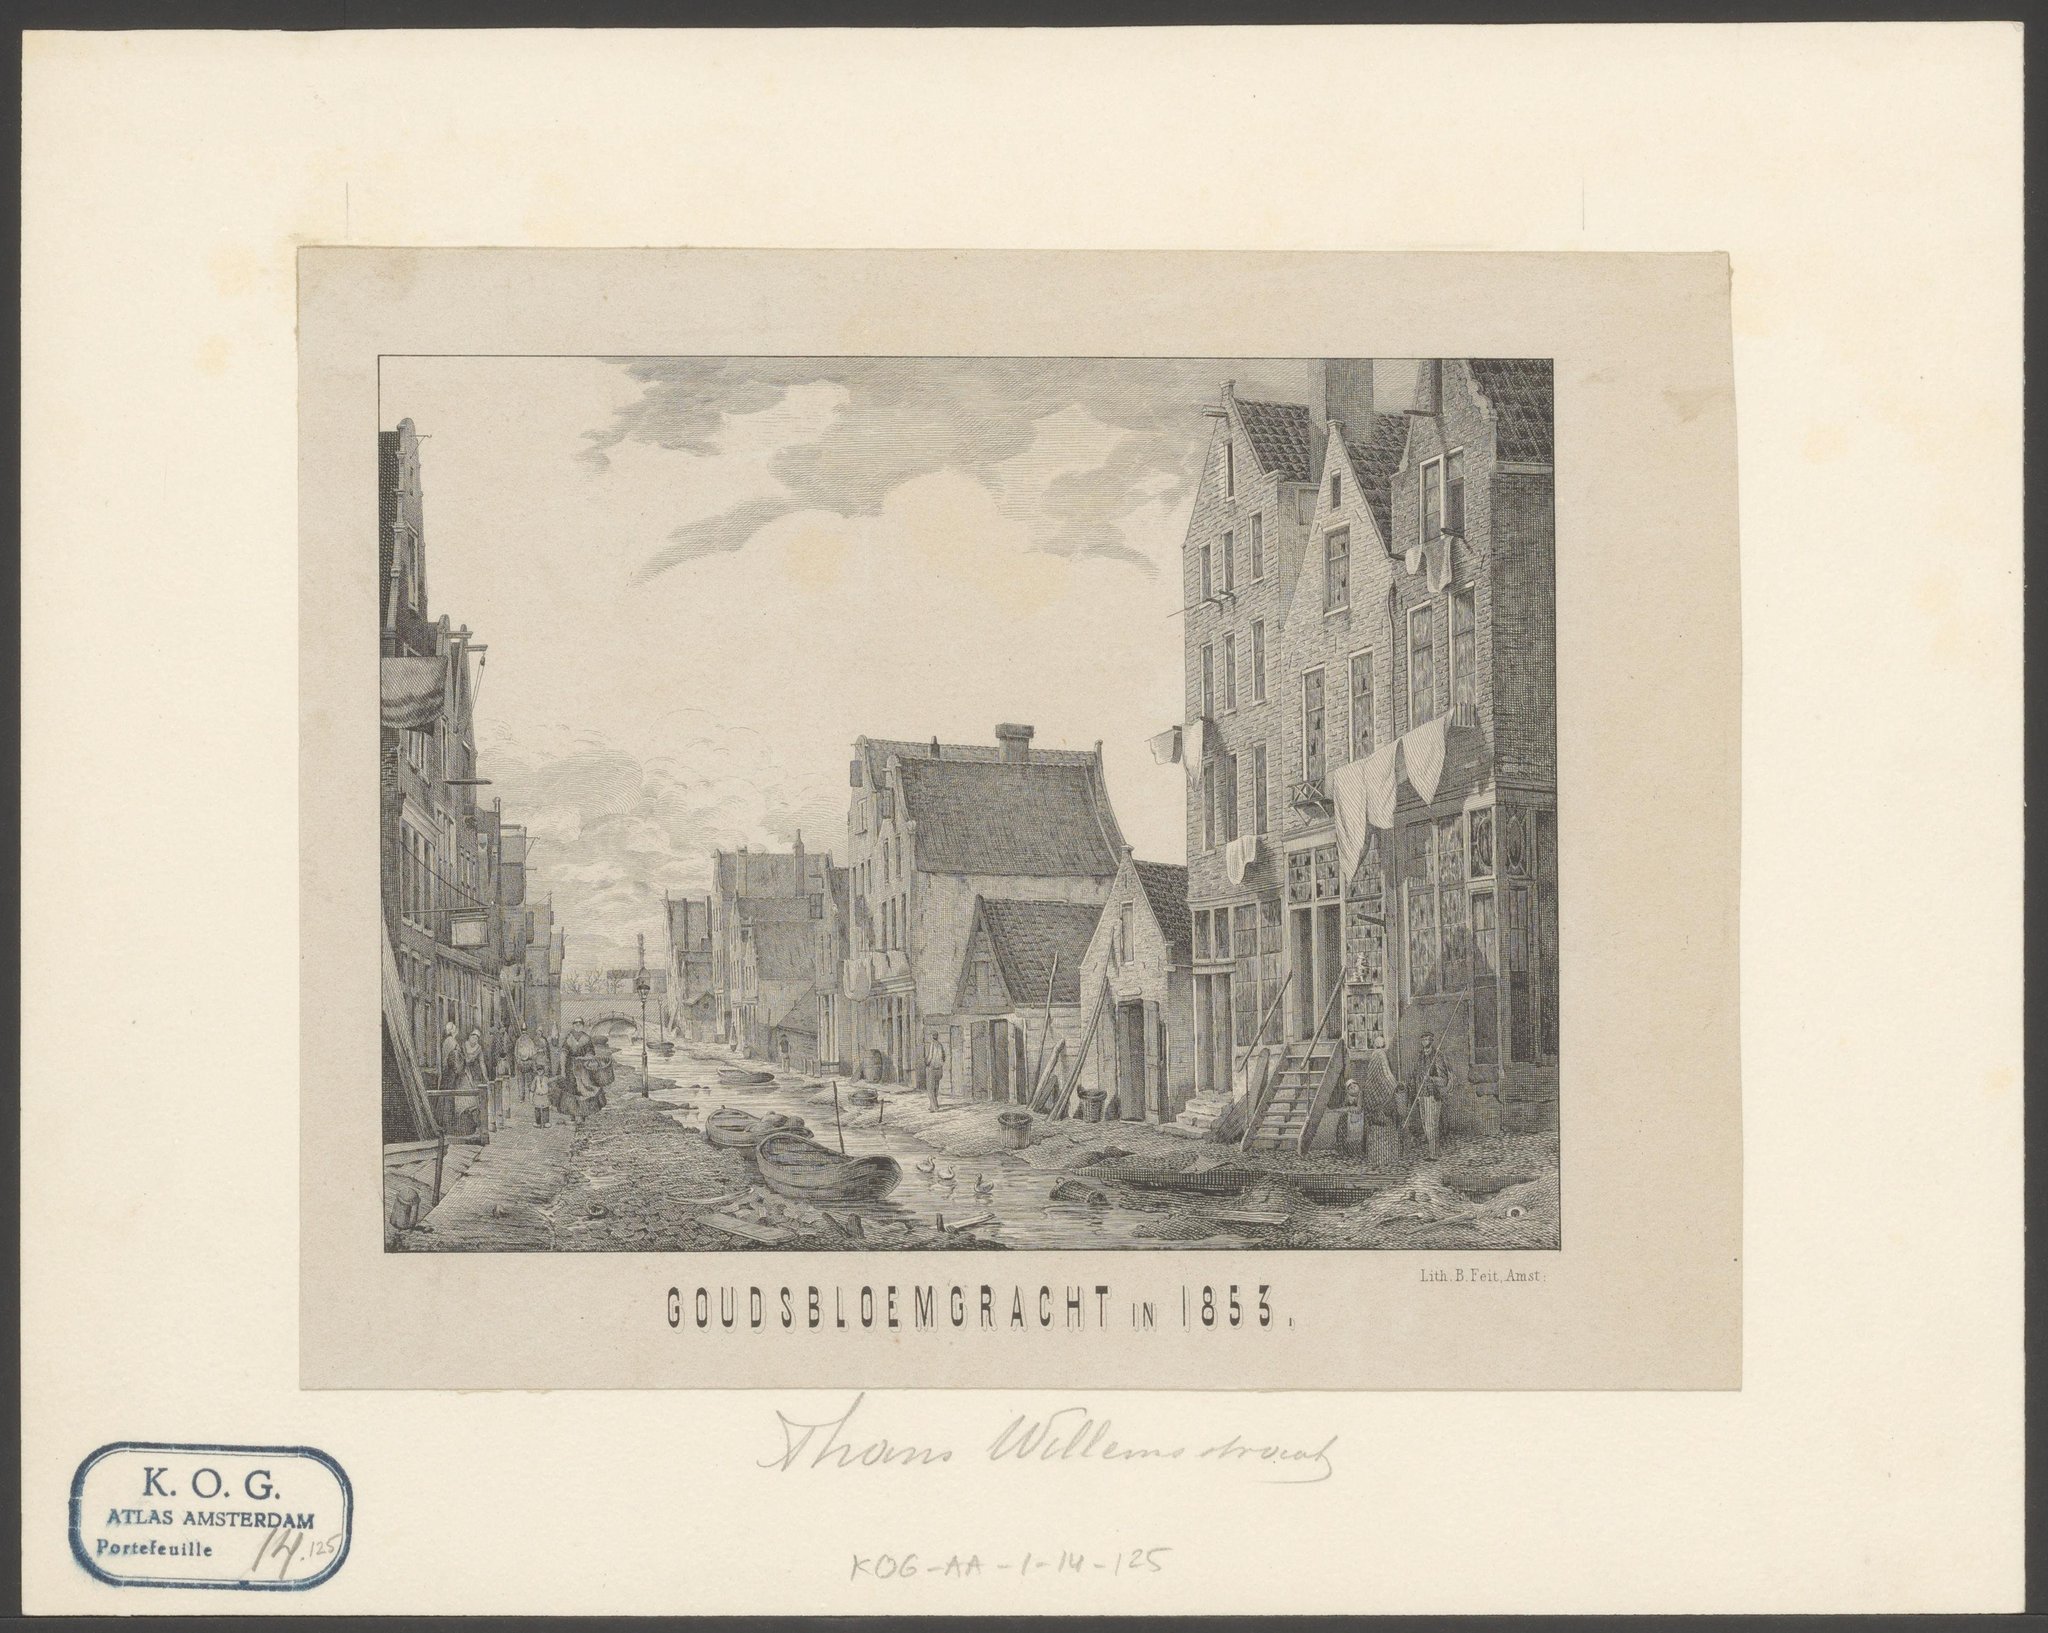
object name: print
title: Gezicht op de Goudsbloemgracht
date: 1851-1883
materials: paper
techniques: lithograph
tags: city-view in general; 'veduta', canal, the usual house or row of houses, street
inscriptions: inscription: ‘Thans Willemstraat’, collector's mark: ‘14.125’ Lugt 1641b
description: Onderwerpsrubriek binnen de Atlas Amsterdam: Waal (Kromme en Oude), Walenpleintje, Warmoesgracht, Warmoesstraat, Waterlooplein, Westerdoksdijk, Westermarkt, Weteringschans, Willemspark, Willemsstraat, Wittenburg, Wittenkade (de), Wittenstraat (de).